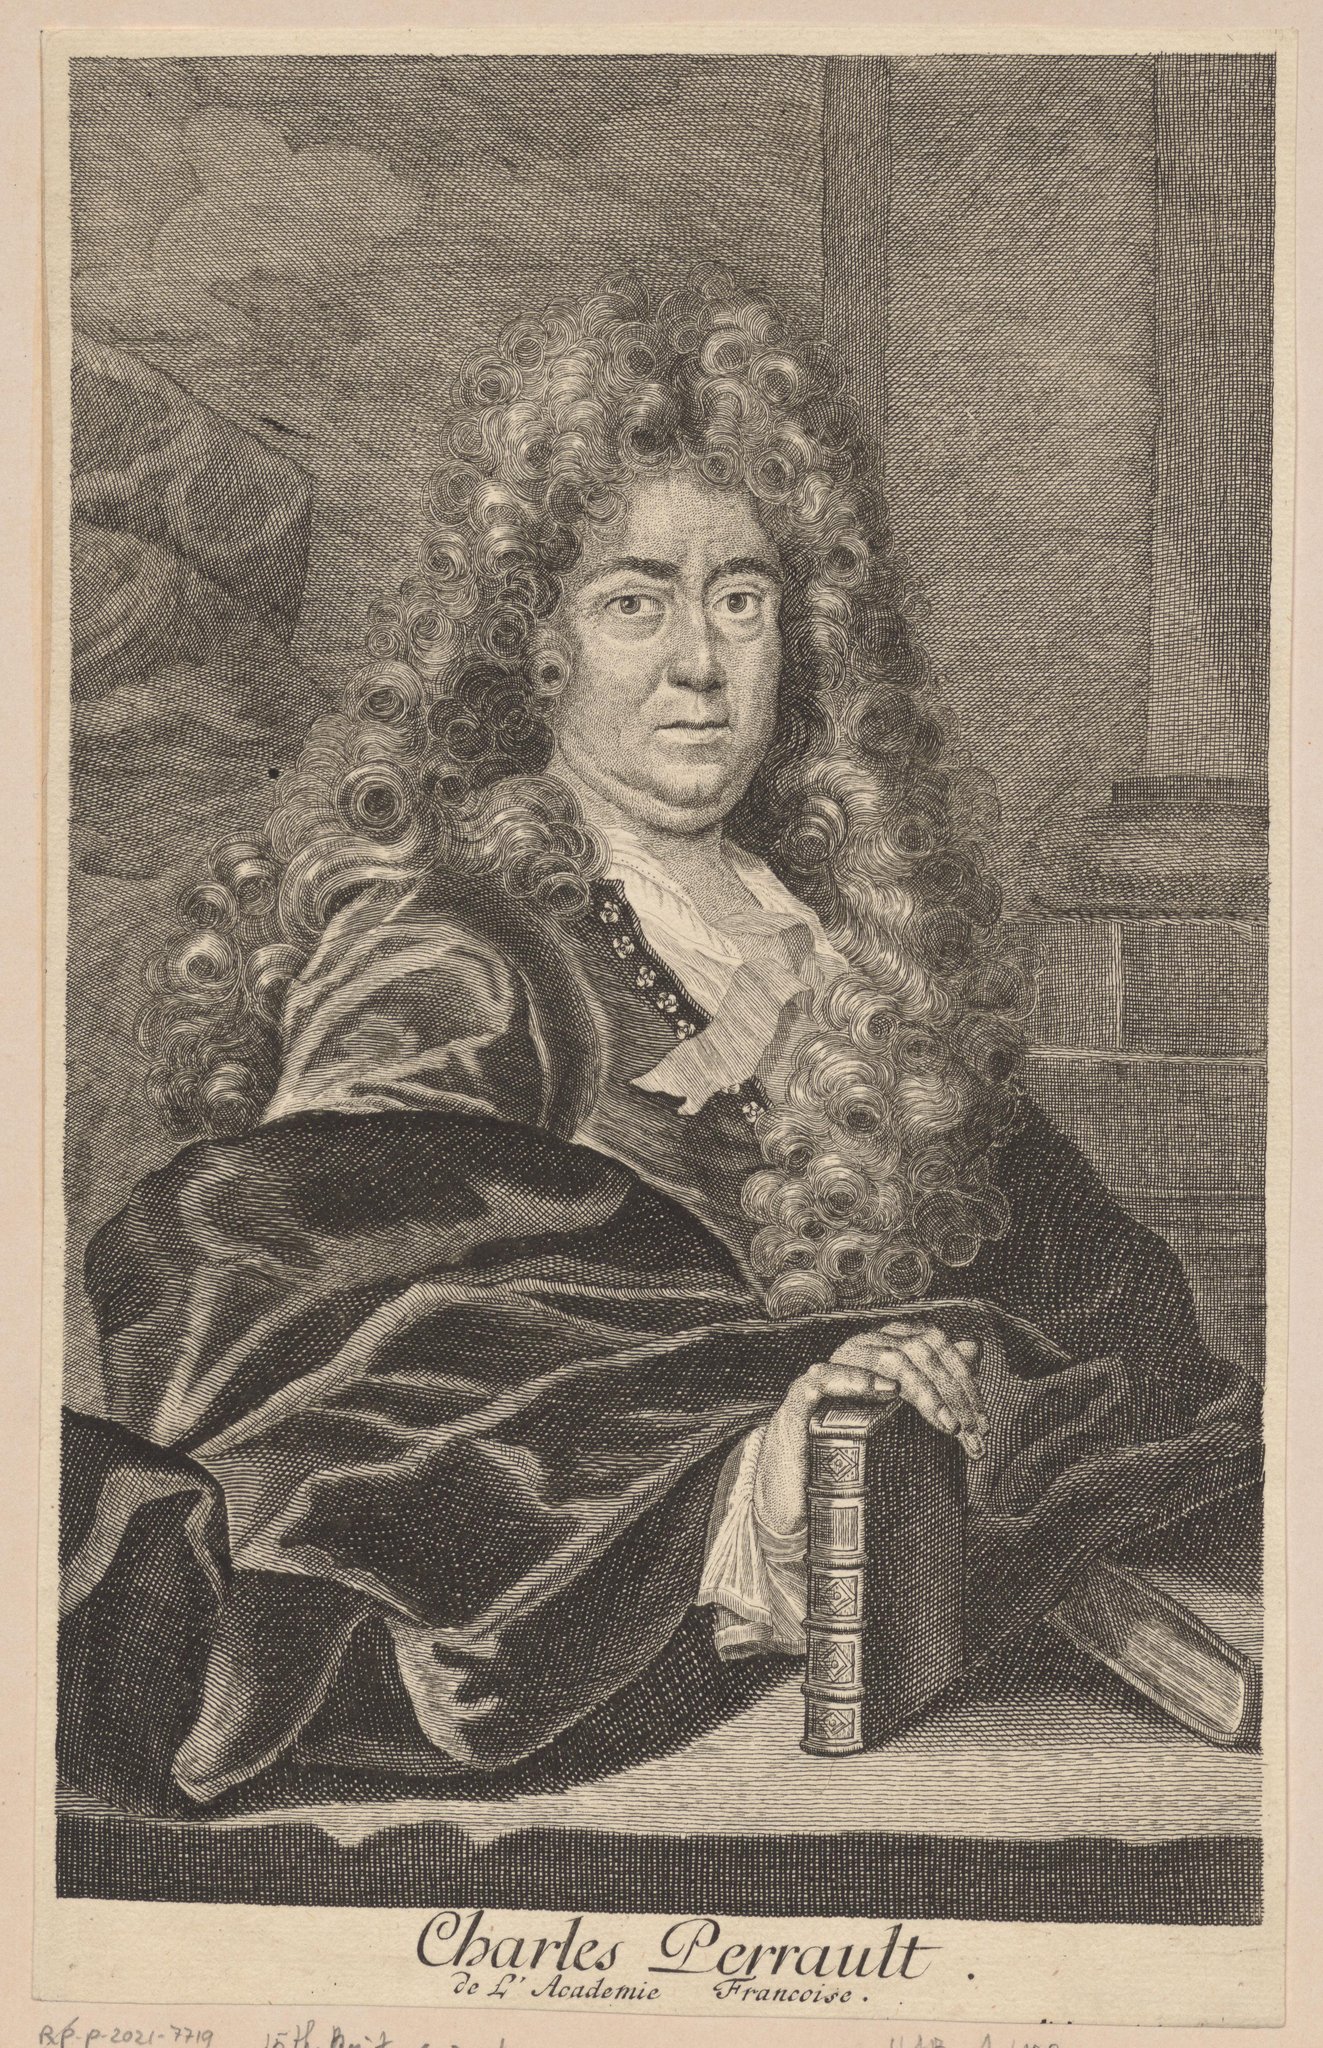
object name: print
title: Portret van Charles Perrault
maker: Anonymous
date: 1694-1749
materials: paper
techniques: engraving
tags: paris, charles perrault, adult man, historical persons, book